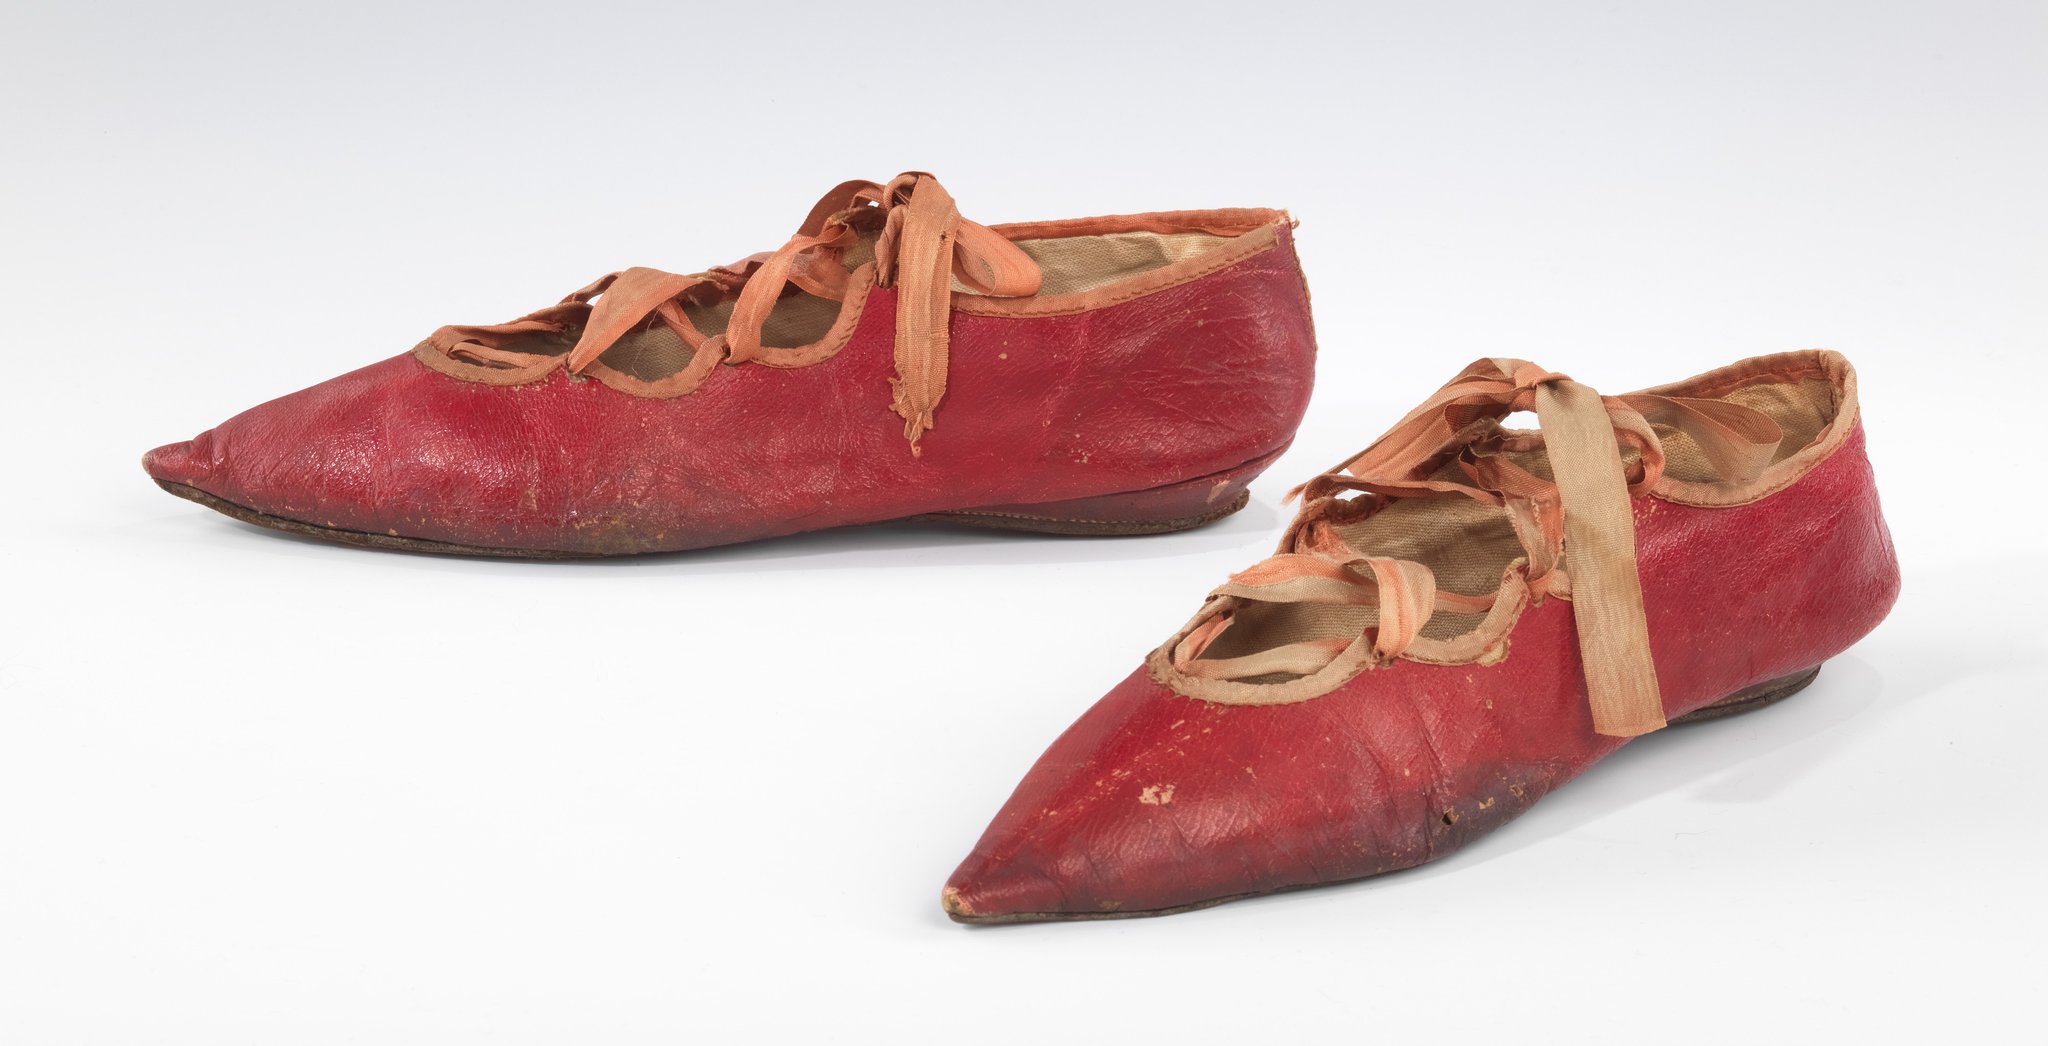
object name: shoe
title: Shoes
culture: british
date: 1795-1805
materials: leather